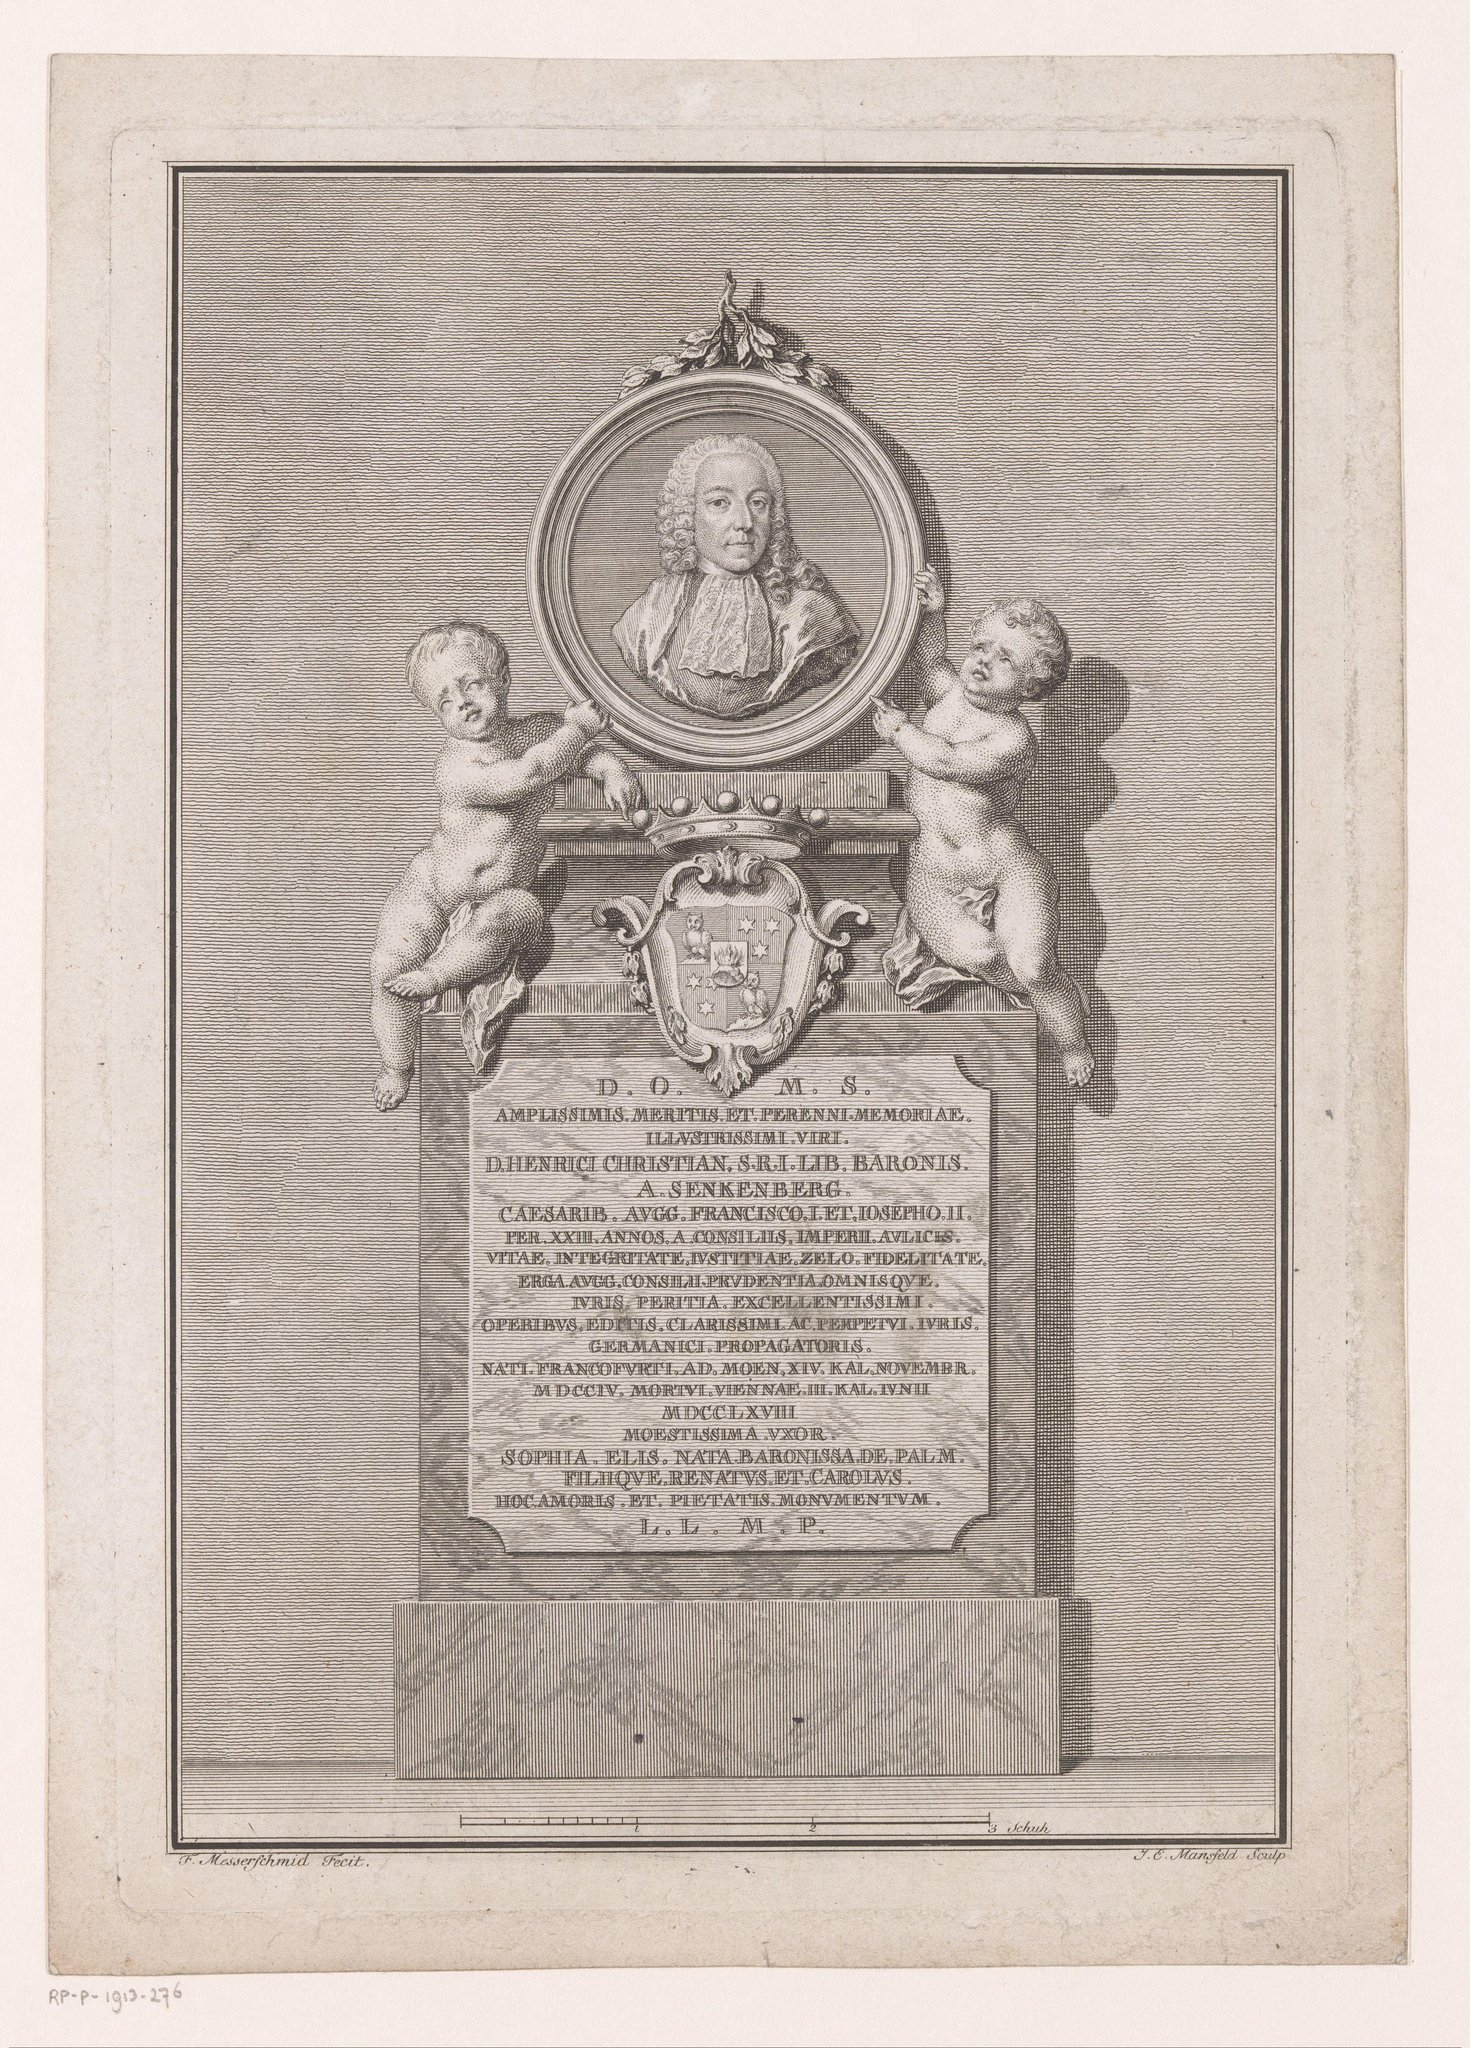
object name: print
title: Monument van Heinrich Christian von Senckenberg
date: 1749-1796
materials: paper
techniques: engraving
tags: vienna, historical persons, monument, statue, armorial bearing, heraldry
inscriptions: collector's mark: Lugt 2228